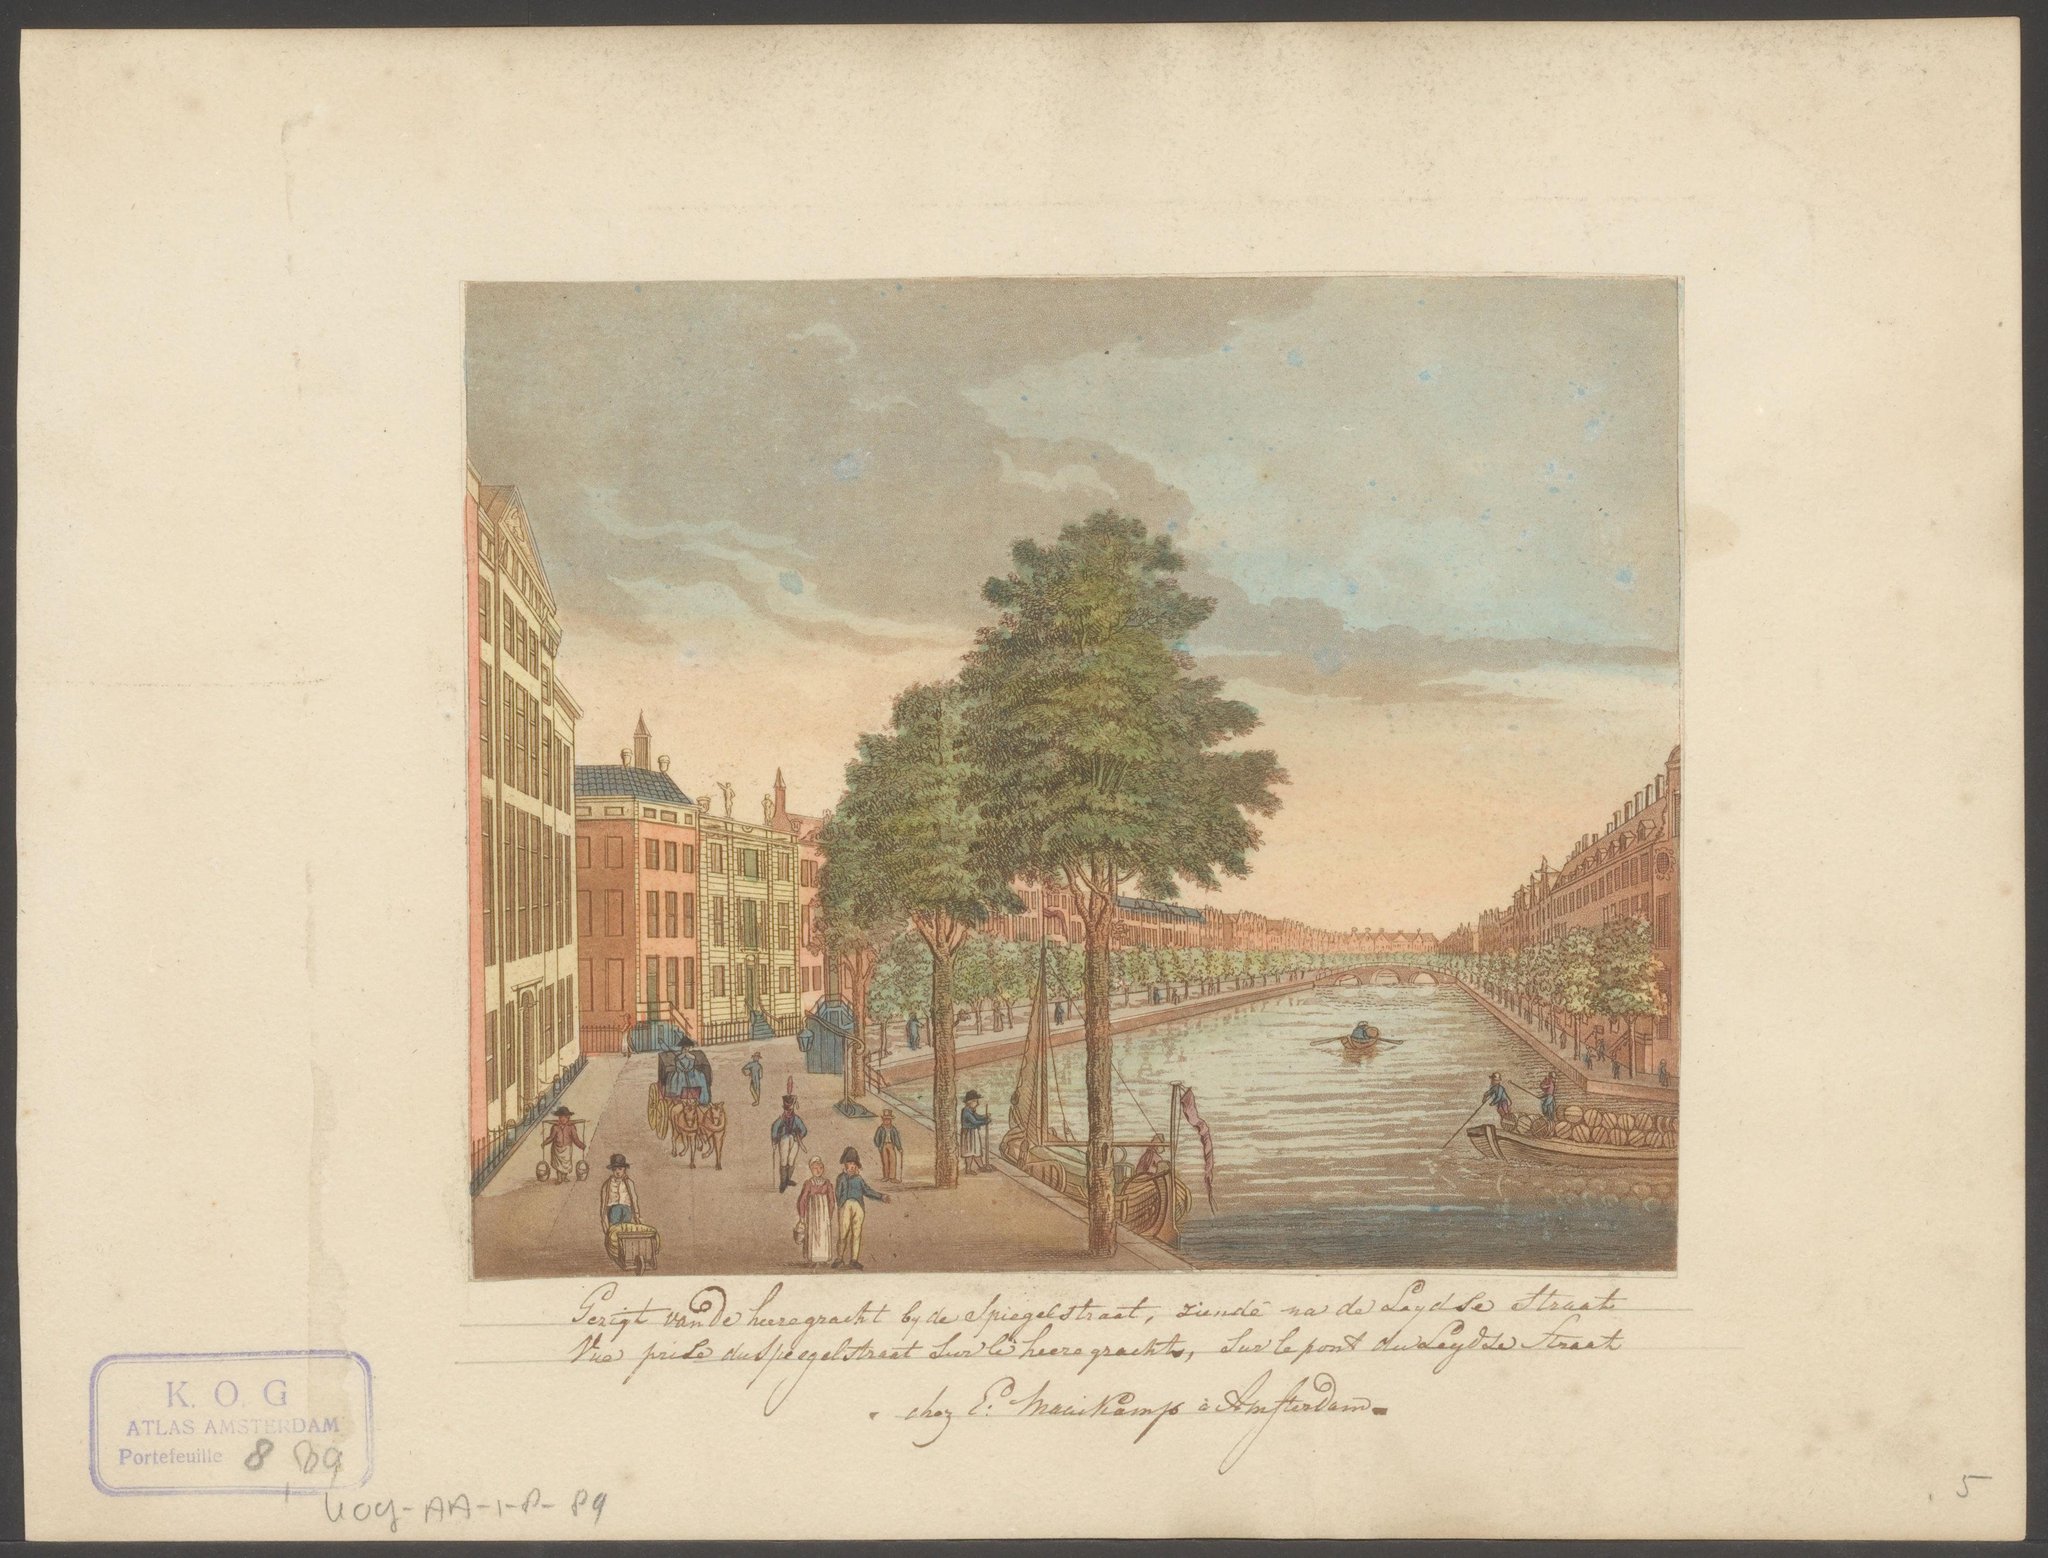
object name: print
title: Gezicht op de Herengracht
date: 1824-1825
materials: paper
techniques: aquatint, etching, hand coloring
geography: amsterdam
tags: city-view in general; 'veduta', canal, bridge in city across river, canal, etc., two-wheeled vehicle drawn by two animals, street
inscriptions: collector's mark: ‘8,89’ Lugt 1641b, inscription: ‘Gezigt van de (...) Maaskamp a Amsterdam’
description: Onderwerpsrubriek binnen de Atlas Amsterdam: Haarlemmerplein, Halvemaansteeg, Handboogstraat, Handelskade, Haringpakkerij, Hartenstraat, Hasseltsteeg (Dirk van), Heerengracht.